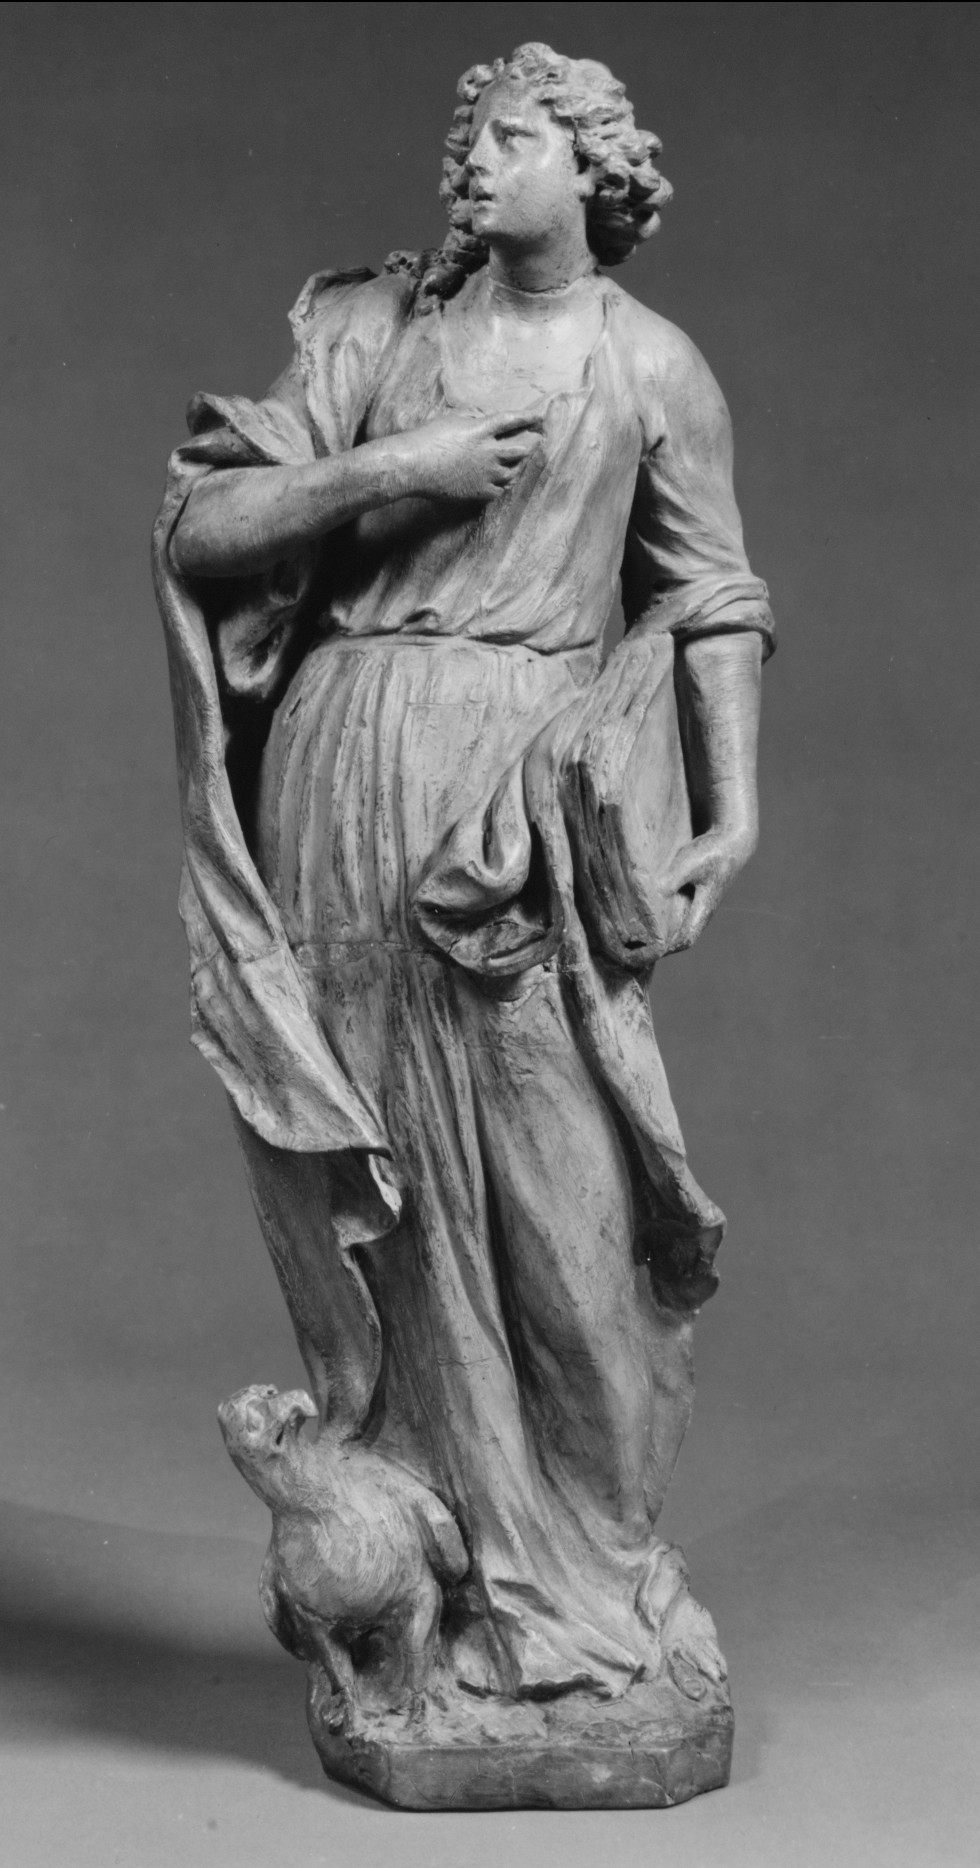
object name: statuette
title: Saint John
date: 1700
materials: terracotta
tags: birds,saint john the evangelist